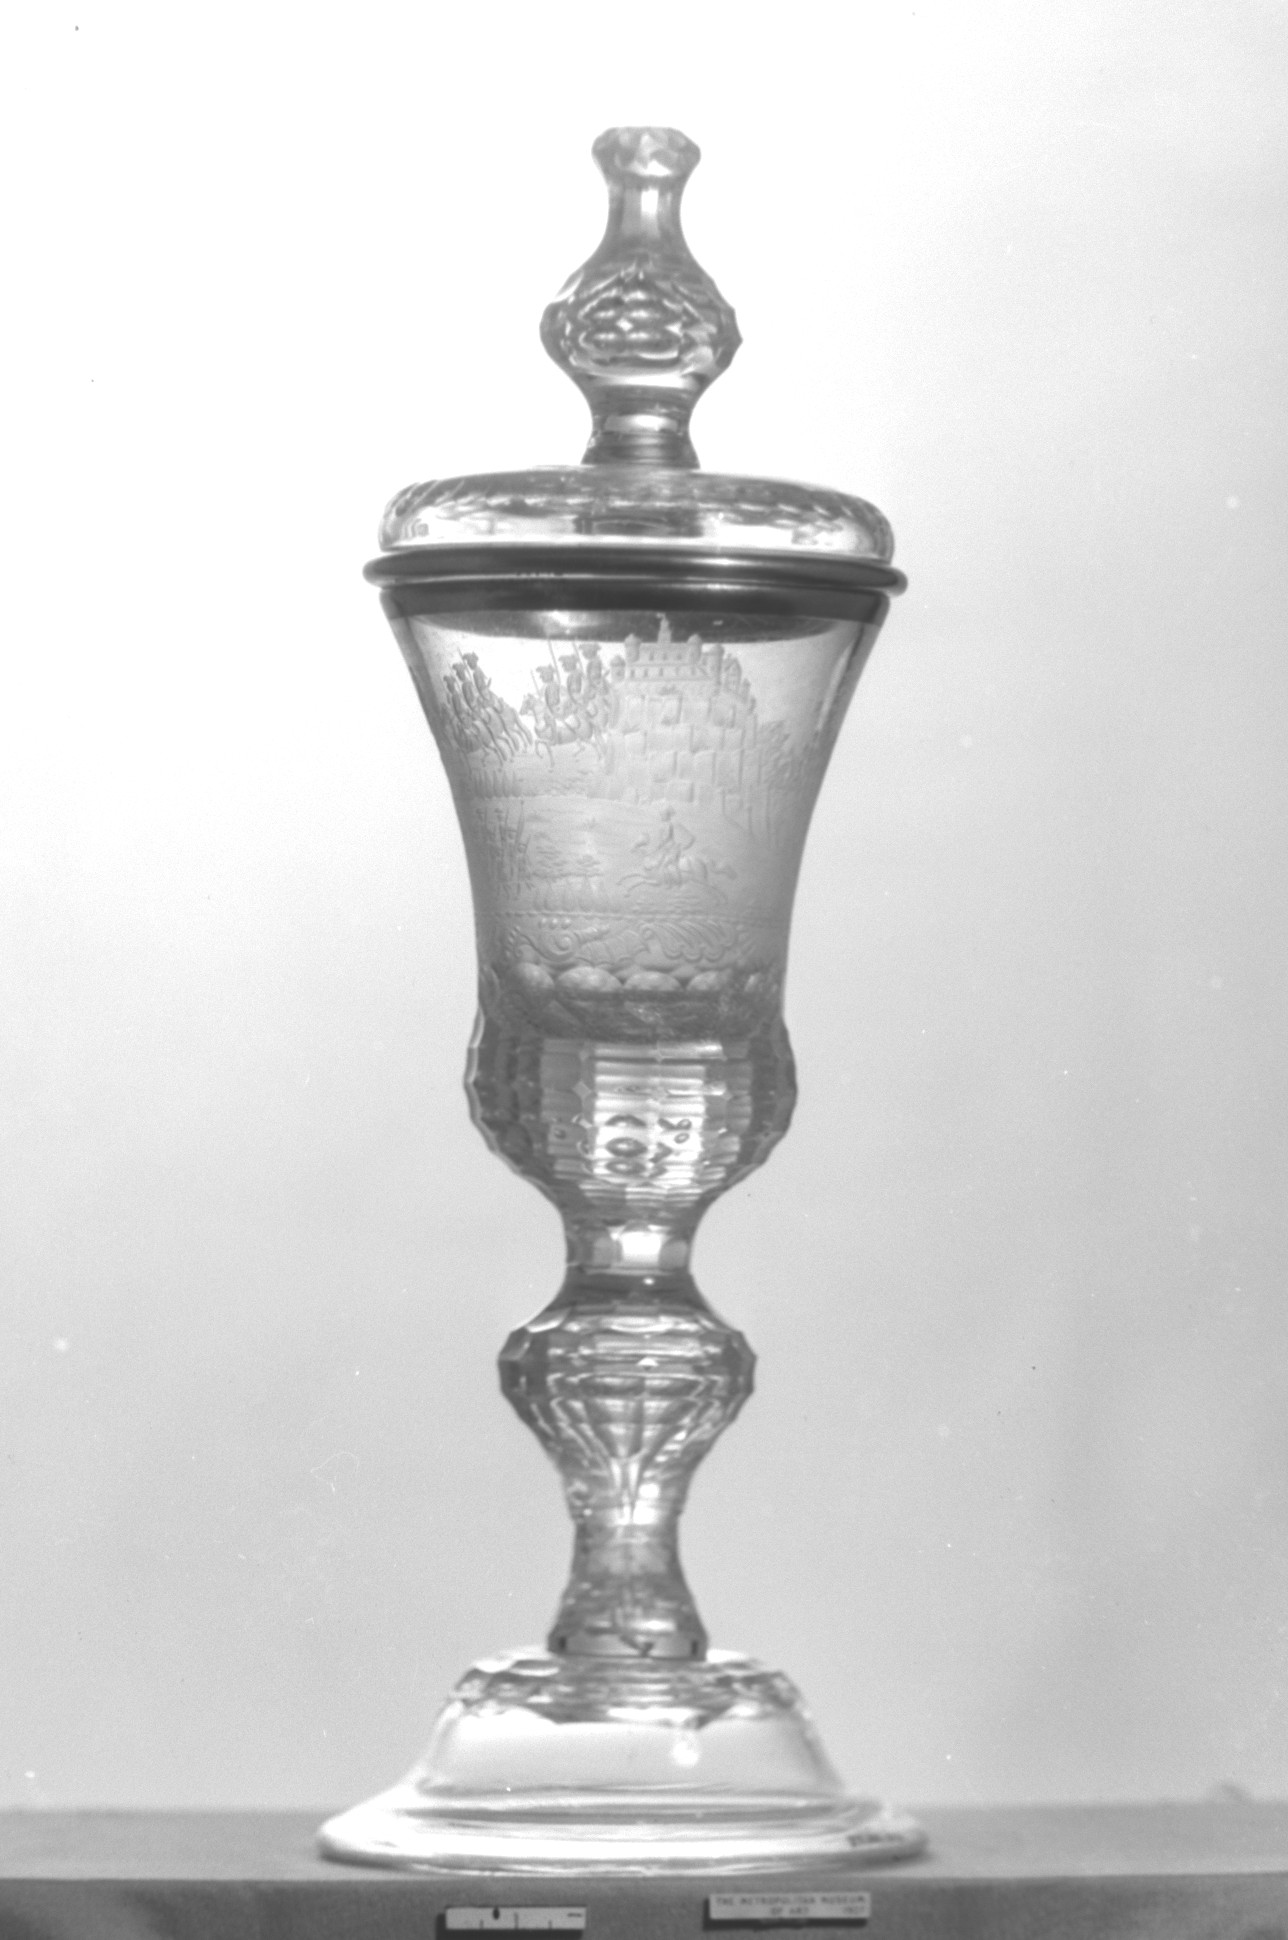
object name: standing cup with cover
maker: lauenstein manufactory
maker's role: manufactory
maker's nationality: german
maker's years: 1701-1801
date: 1760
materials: glass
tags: human figures,buildings,horses